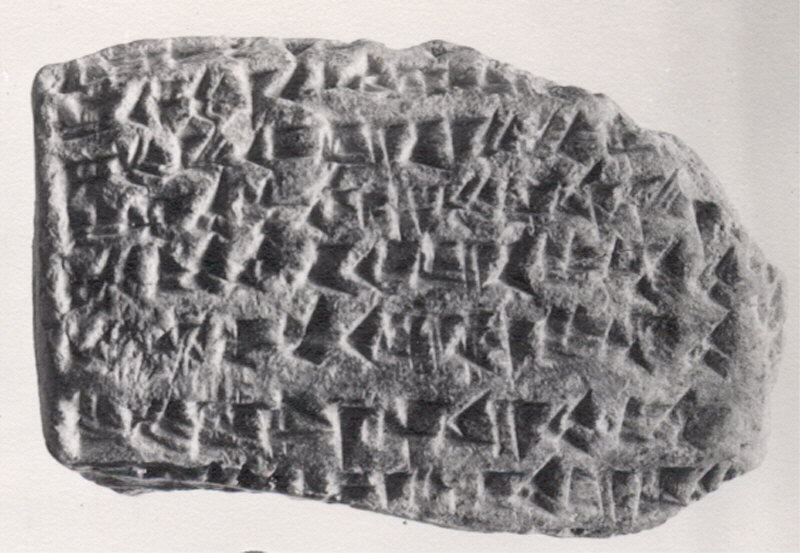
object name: cuneiform tablet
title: Cuneiform tablet: fragment of a field lease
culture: achaemenid or babylonian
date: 700-301 BCE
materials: clay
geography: mesopotamia